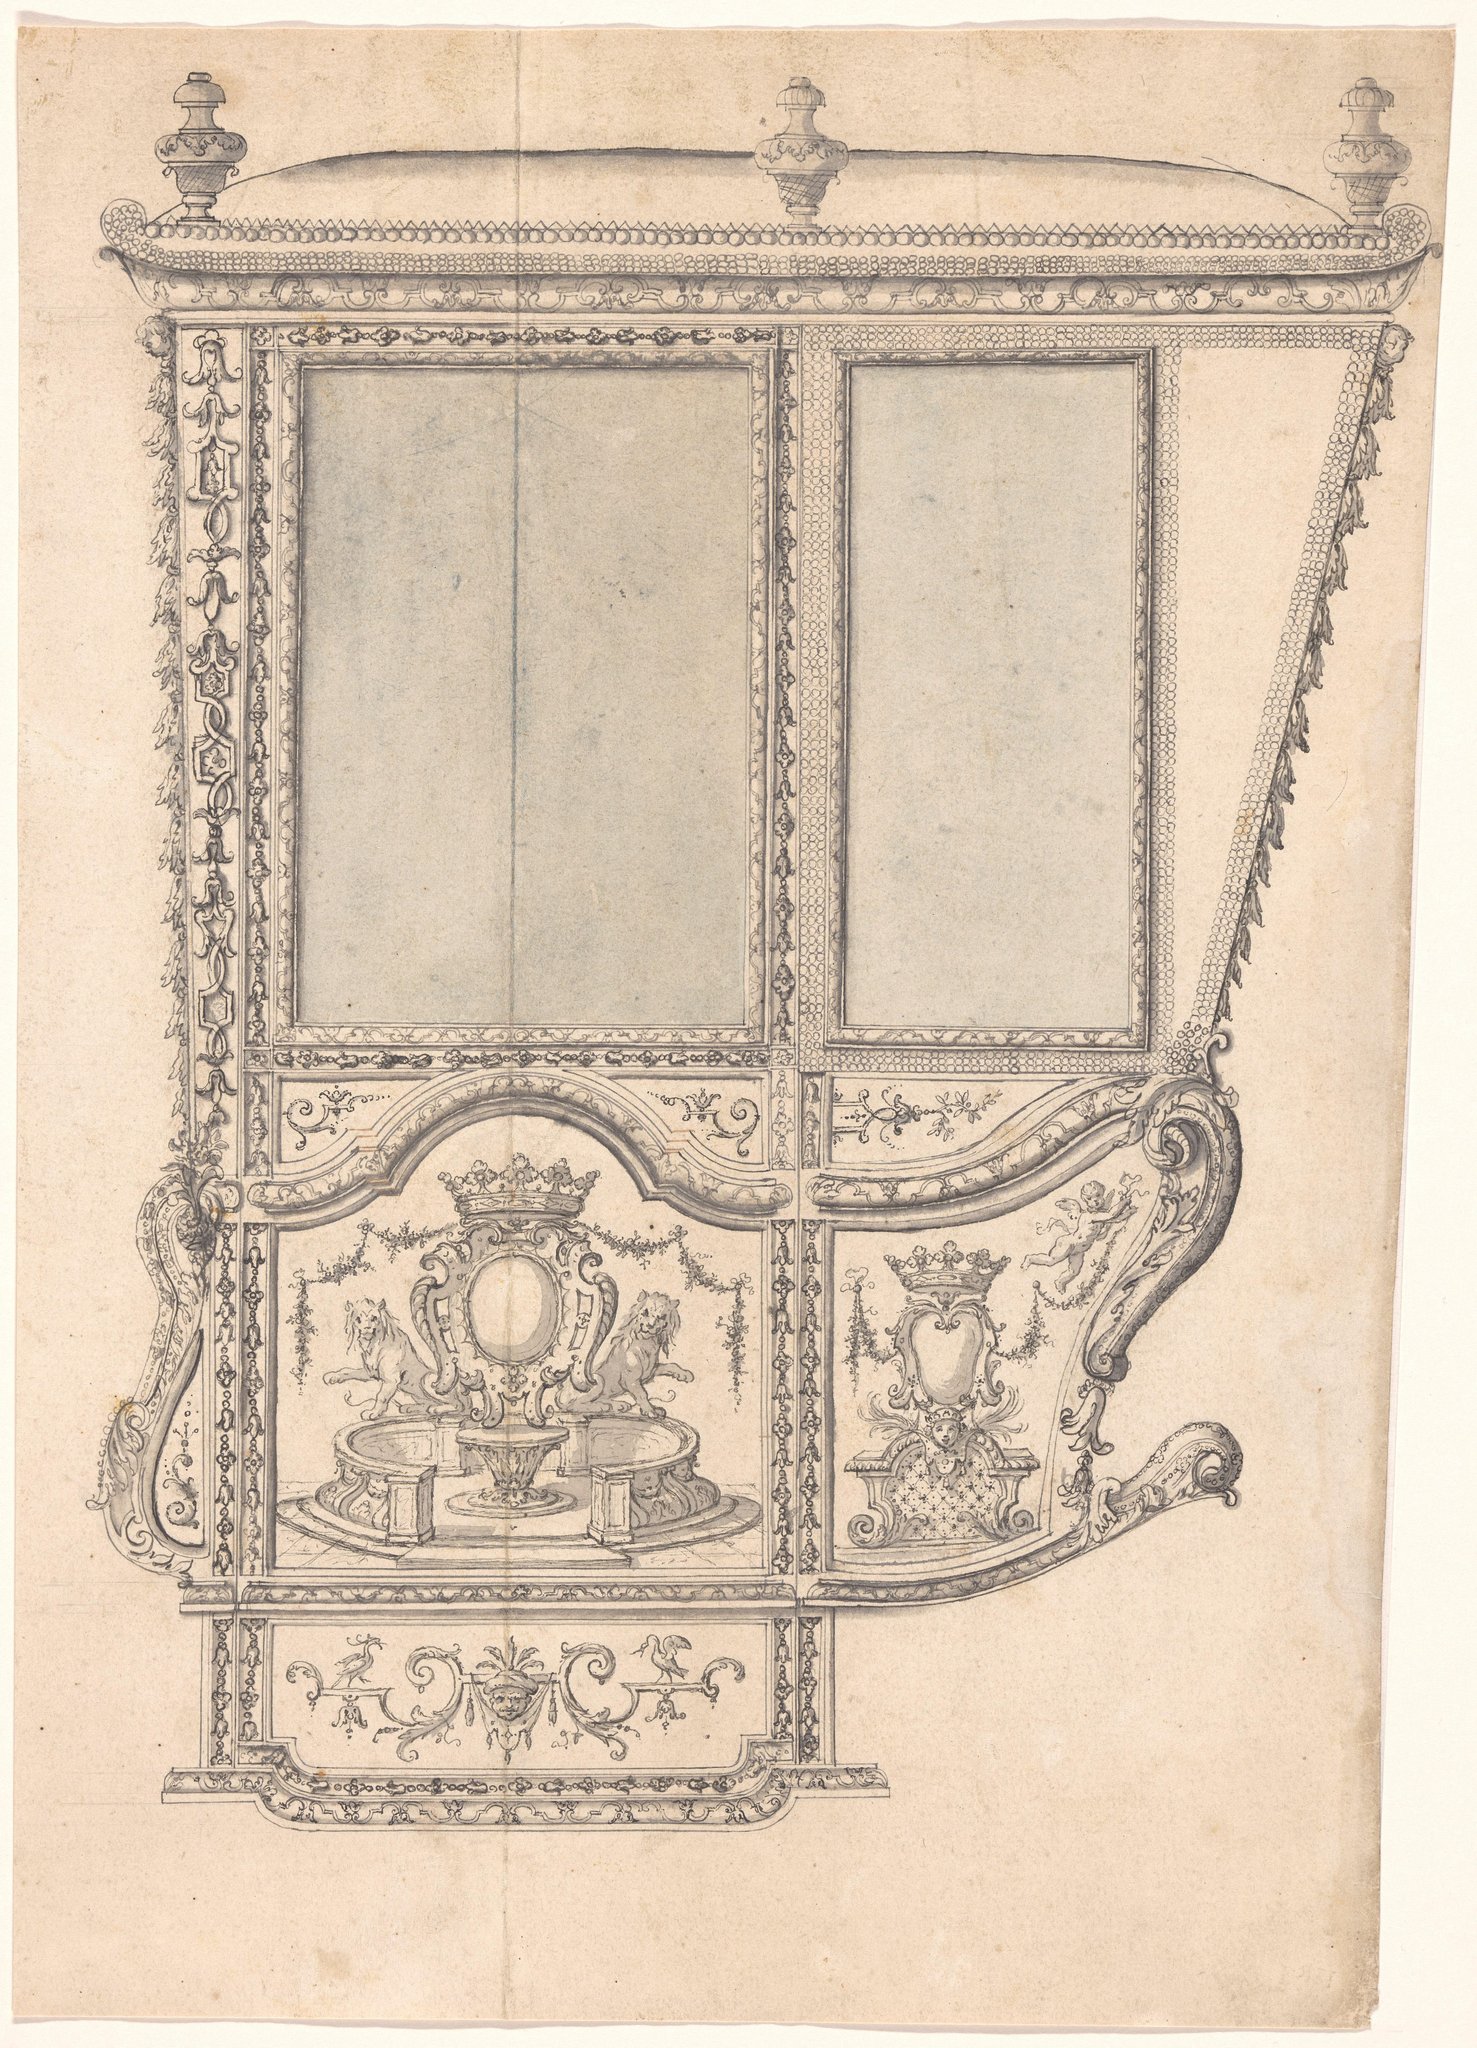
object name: design drawing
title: Ontwerp voor (de beschildering van) een rijtuig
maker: Anonymous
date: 1700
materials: paint, graphite, ink, paper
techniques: brush, pen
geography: paris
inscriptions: watermark